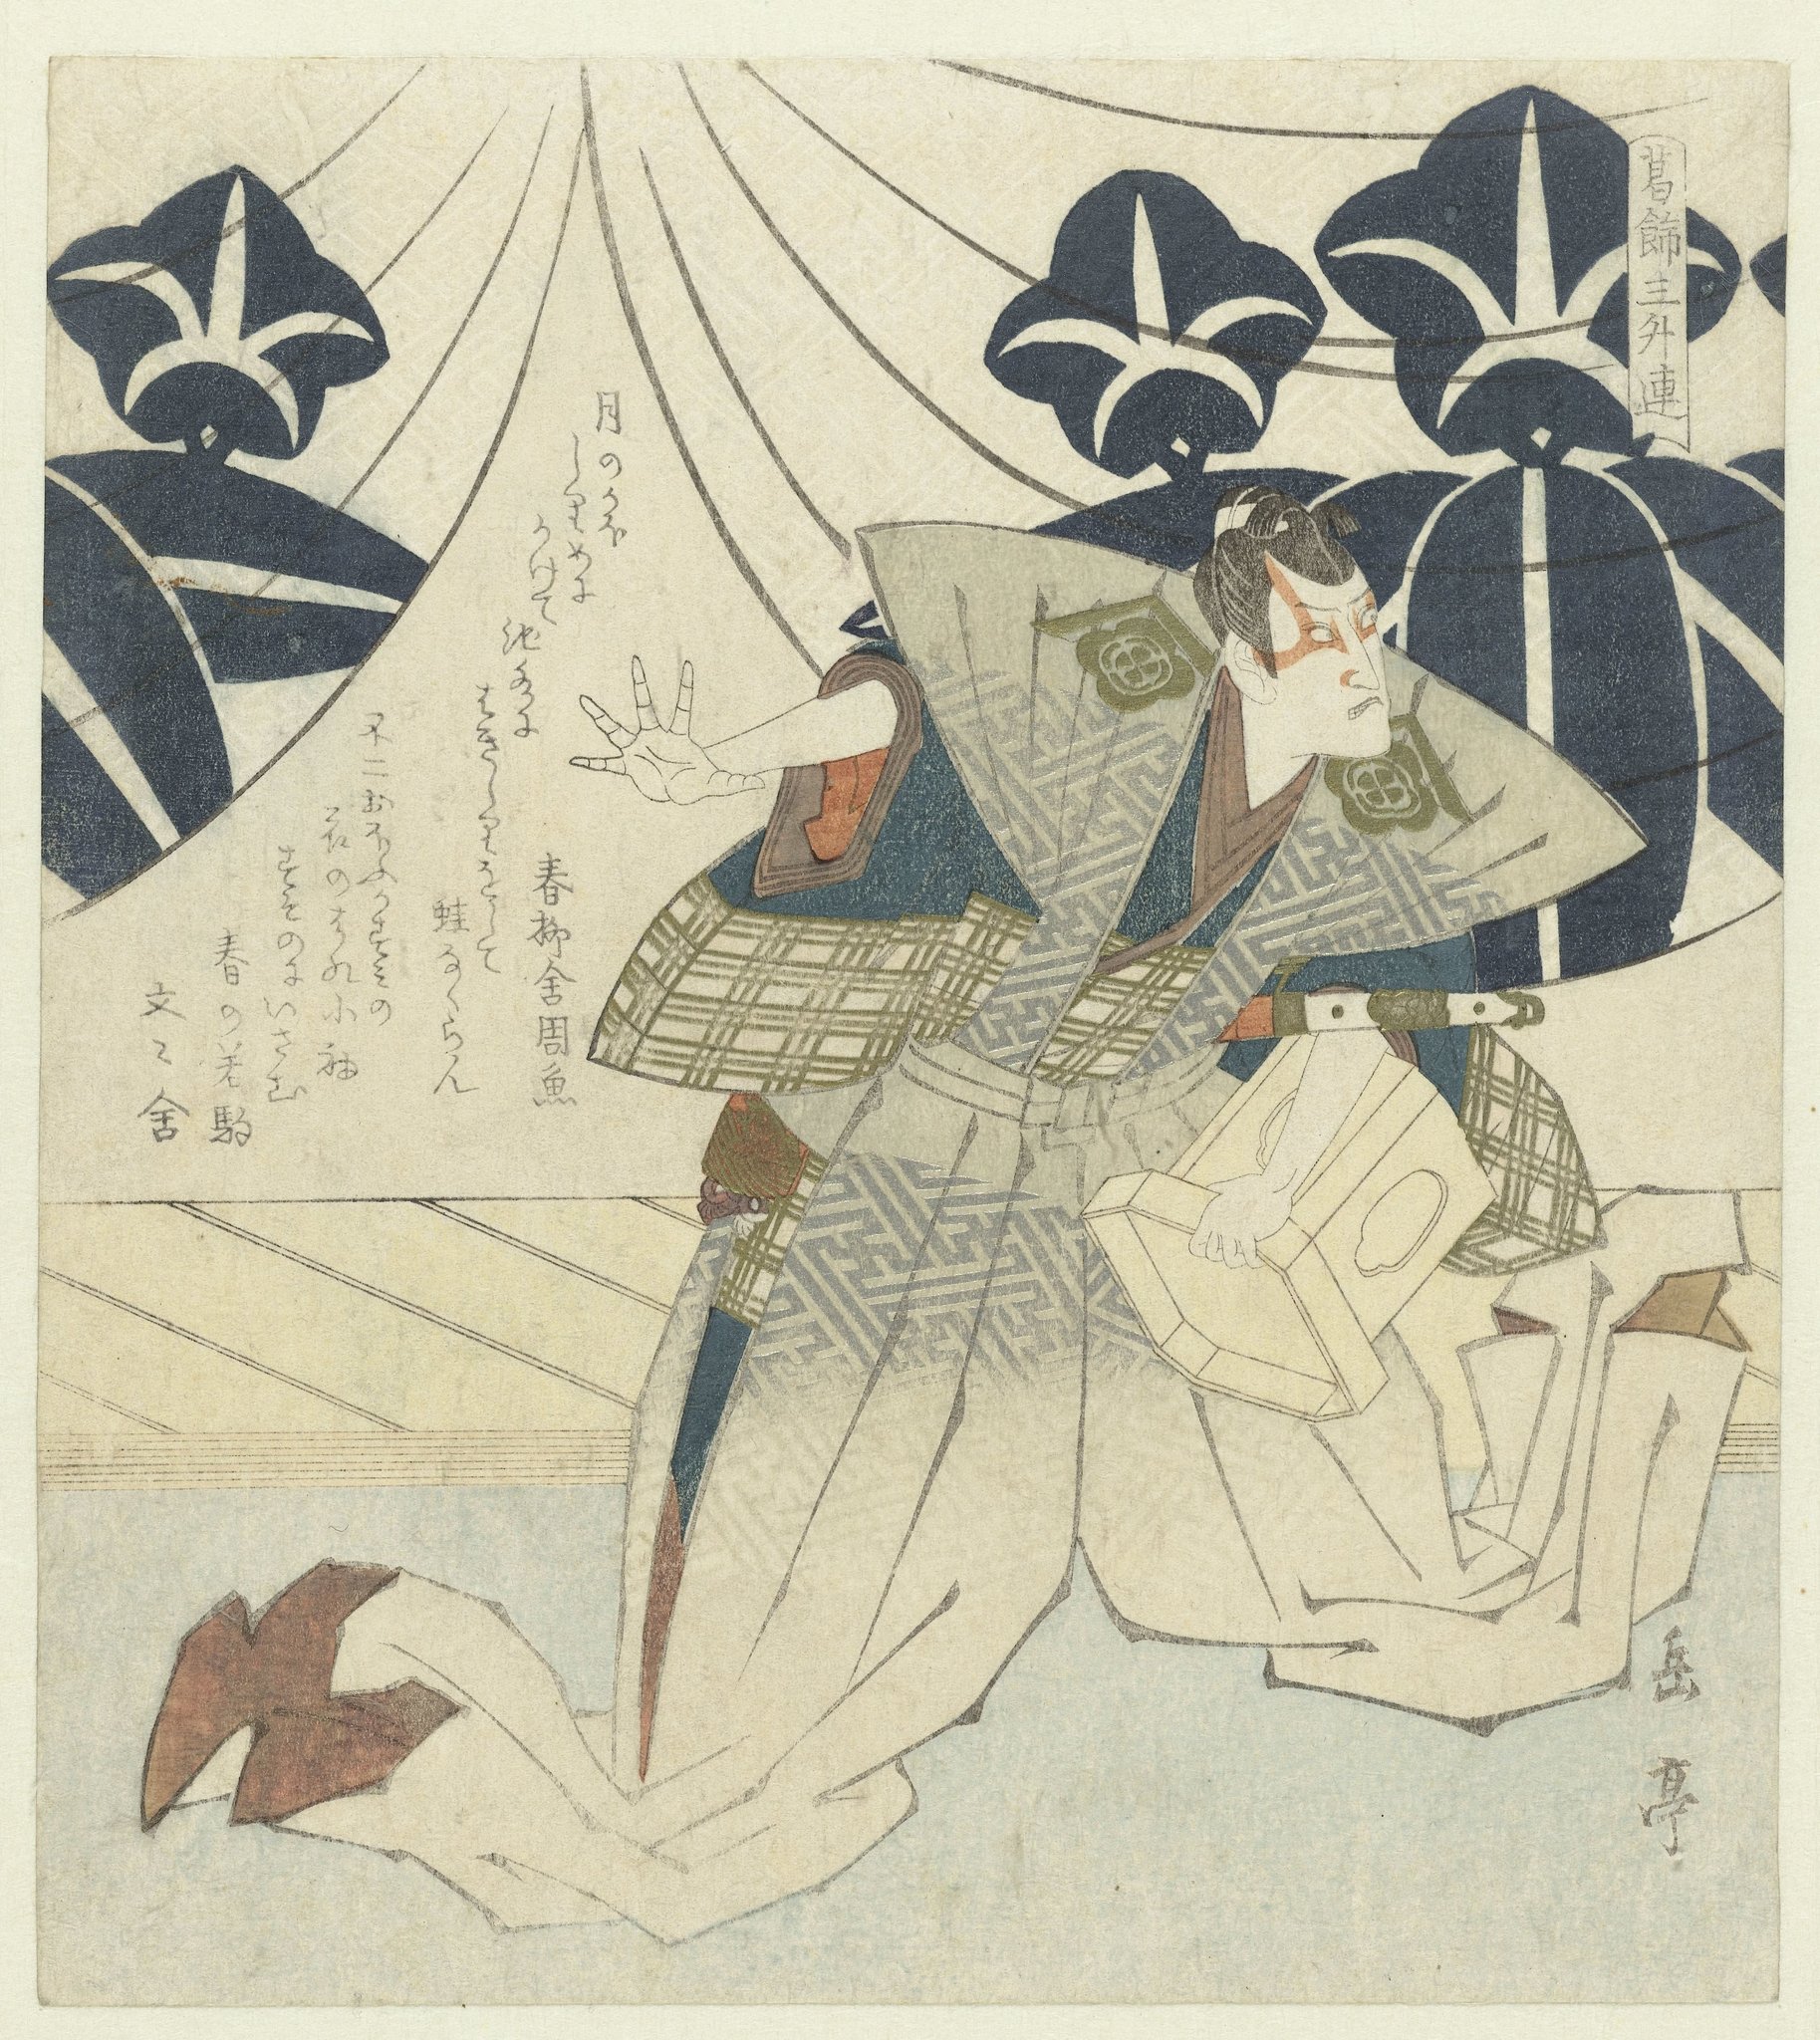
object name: print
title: Soga no Gorô Tokimune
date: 1823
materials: paper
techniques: blind stamped, woodcut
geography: japan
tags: actor (on the stage)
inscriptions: collector's mark, passe-partout, bottom left, printed: JABdH with a rooster., collector's mark, verso, stamped: Lugt 2228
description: Een surimono is een luxe uitgevoerde prent waarop beeld met één of meerdere gedichten gecombineerd is. Bij het drukken van een surimono werd vaak gebruik gemaakt van dikker papier, blinddruk en metaal pigmenten, zoals koper- en zilverpoeder. De prenten werden vaak in opdracht van dichters gemaakt en als exclusief geschenk aan vrienden en relaties gegeven.